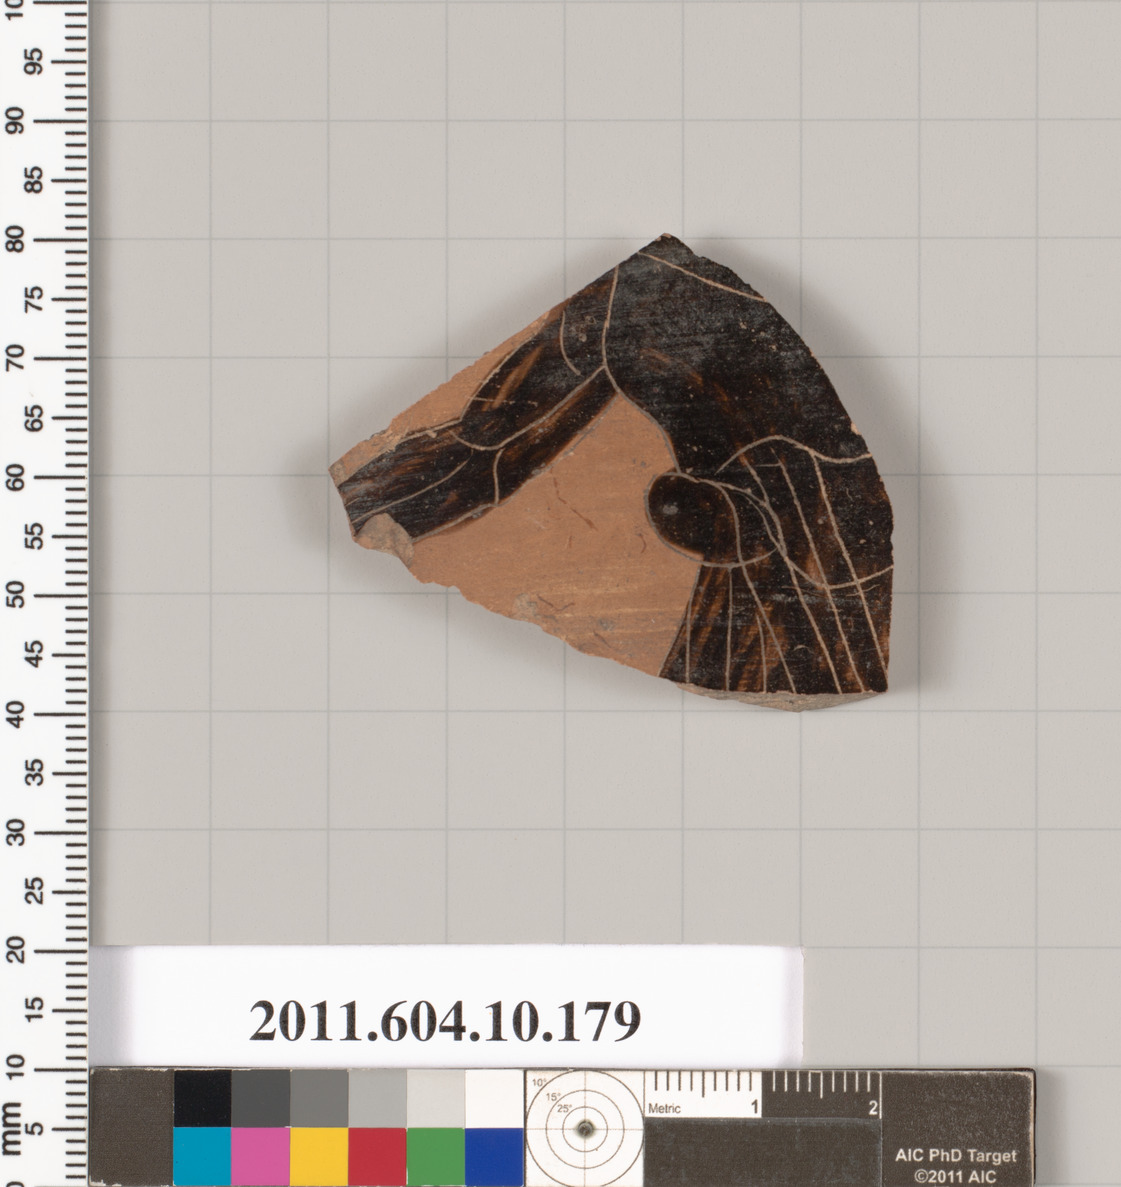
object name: undetermined closed shape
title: Terracotta fragment of a closed shape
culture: etruscan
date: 534-468 BCE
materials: terracotta